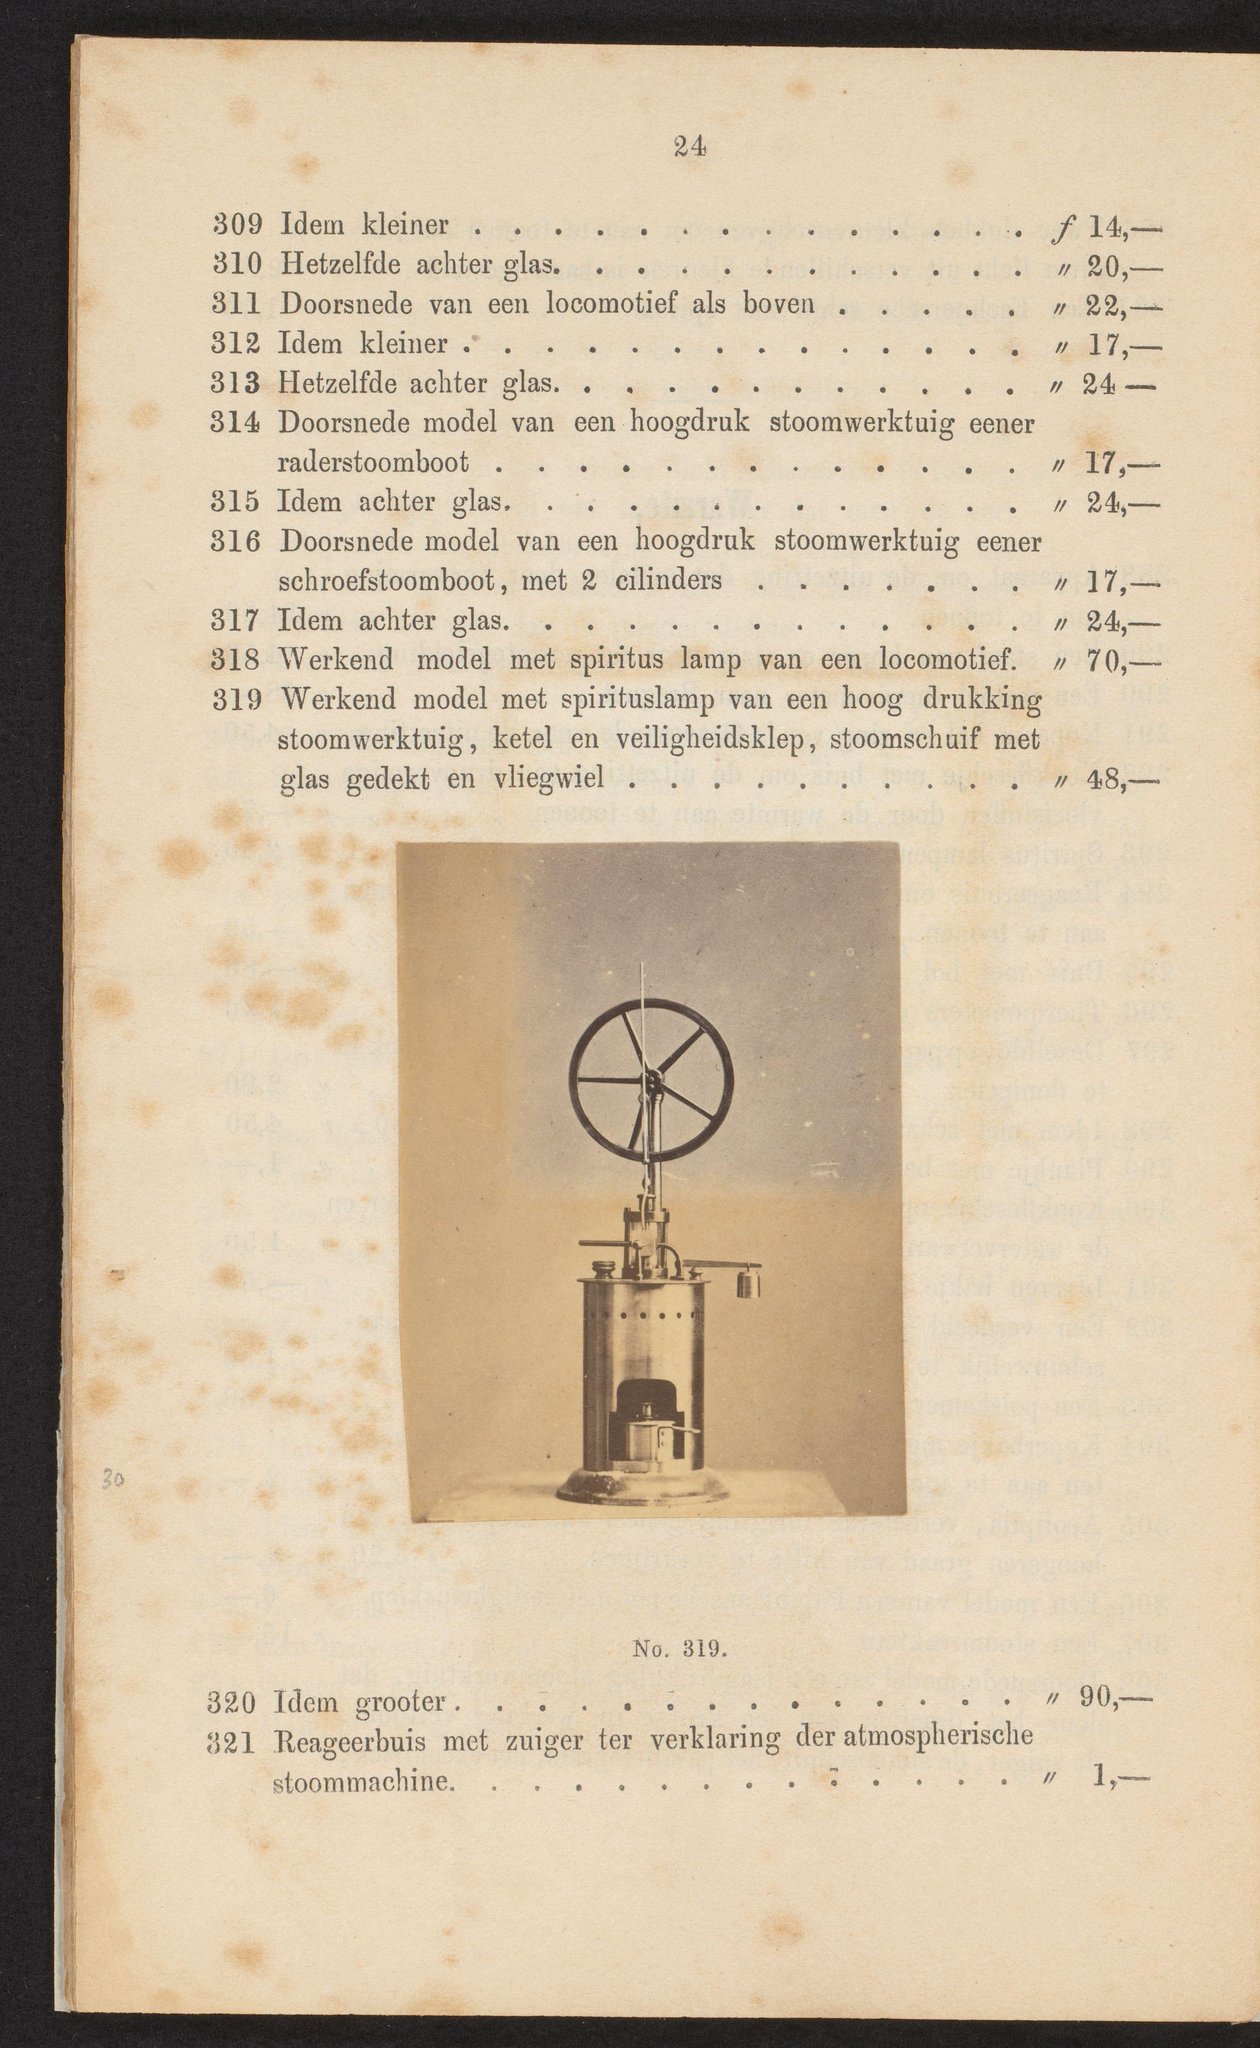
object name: photograph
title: Model van een stoommachine met een spirituslamp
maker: fredrich wilhelm funckler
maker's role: instrument maker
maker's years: 1836-1886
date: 1857-1867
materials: photographic support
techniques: albumen print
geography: netherlands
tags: machine driven by steam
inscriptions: number: ‘No. 319.’